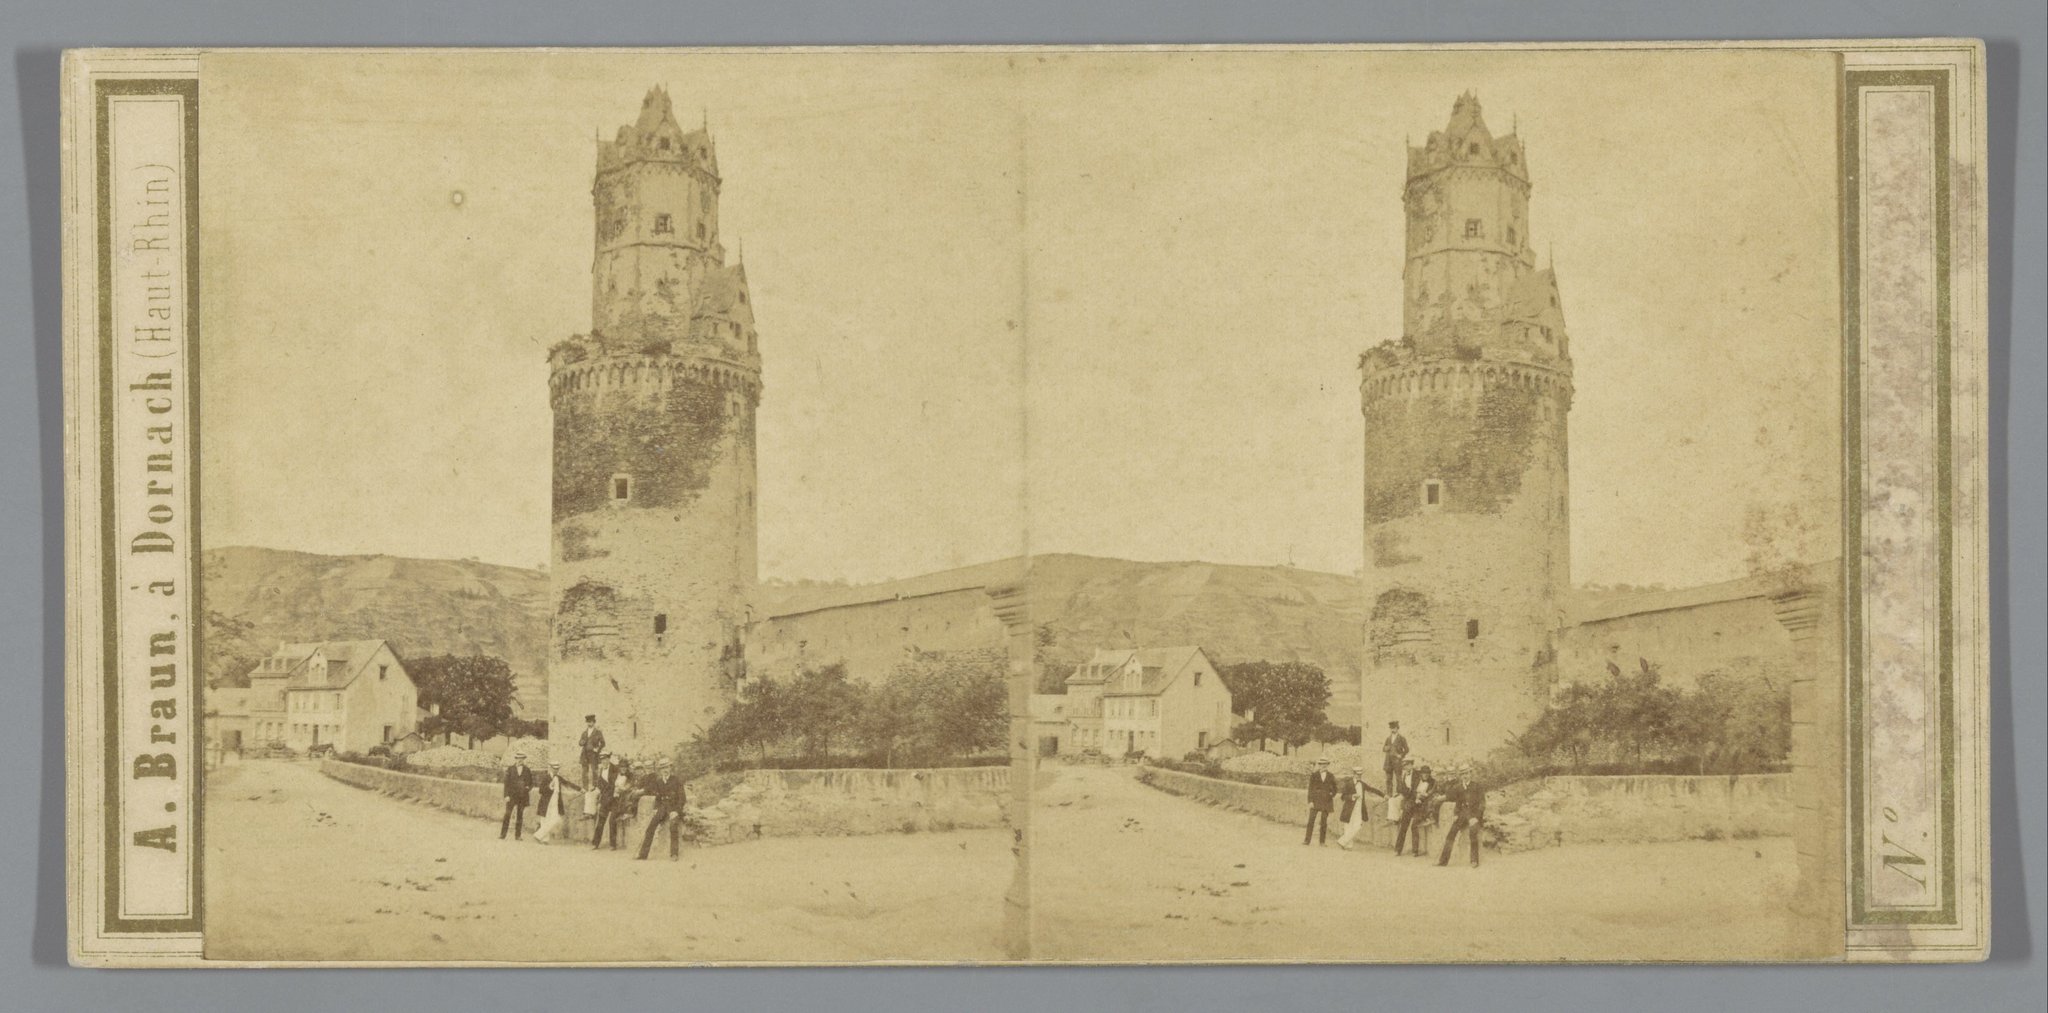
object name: stereograph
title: La Tour ronde à Andernach / Der runde Thurm in Andernach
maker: Anonymous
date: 1860-1866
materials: cardboard, paper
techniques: albumen print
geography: dornach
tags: towers ~ fortified city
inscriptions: number: ‘812.’